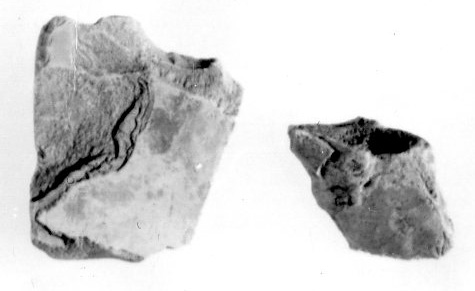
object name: relief fragment, tomb of meketre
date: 1981-1975 BCE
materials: limestone, paint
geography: egypt